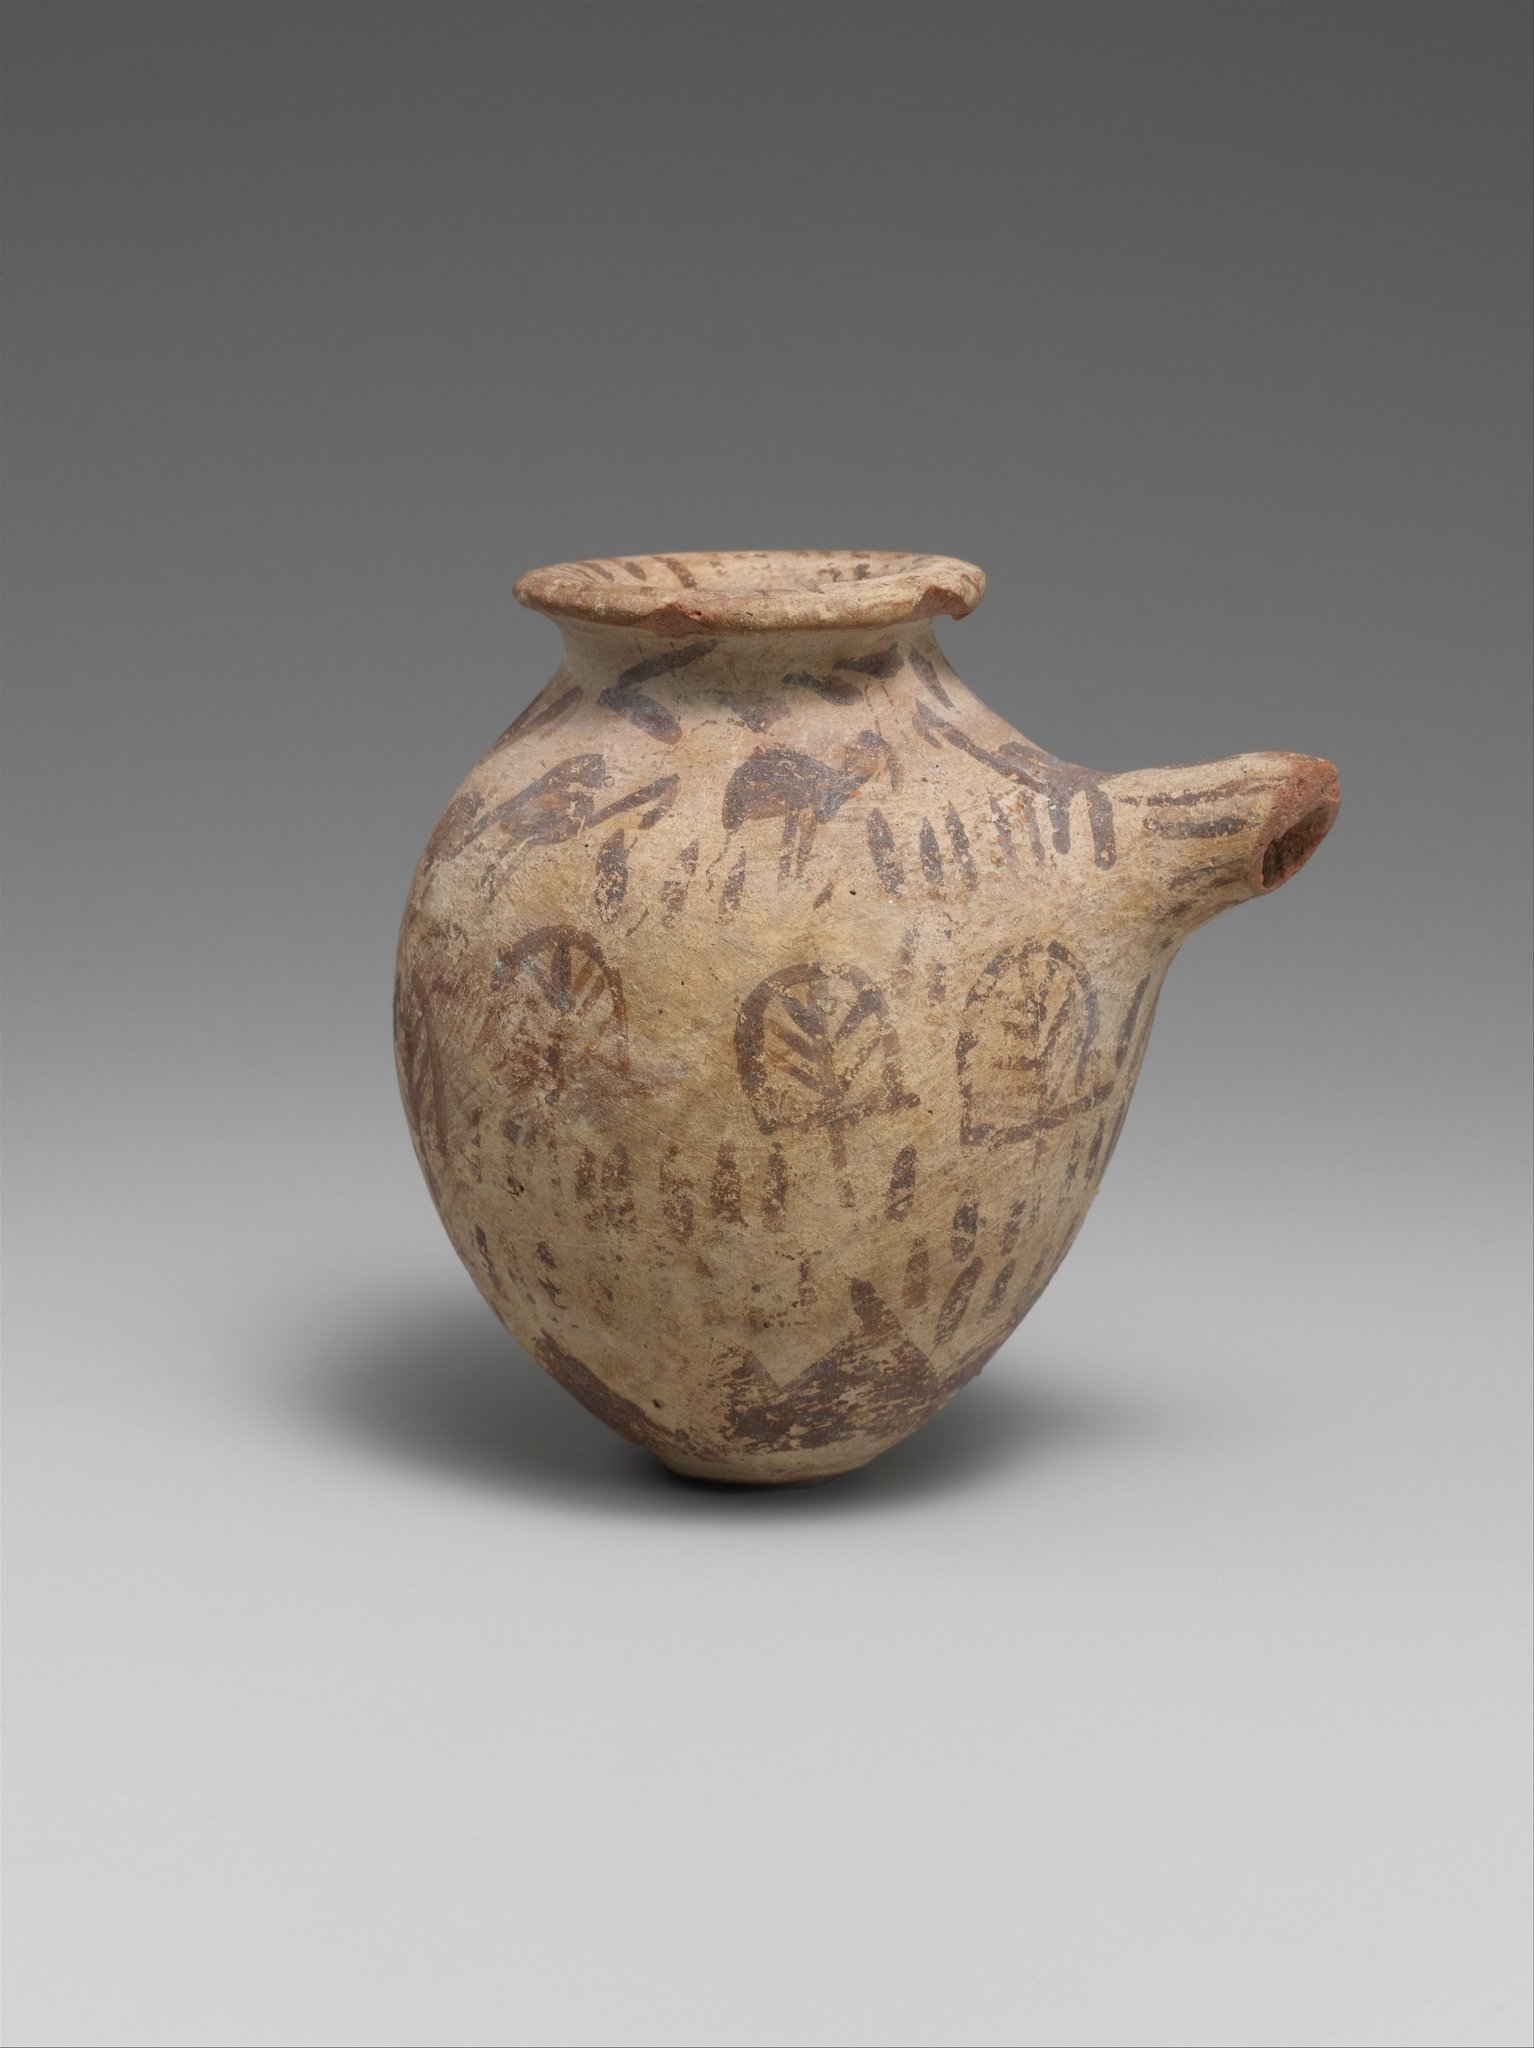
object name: vessel, decorated ware, spouted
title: Spouted vessel in decorated ware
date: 3500 BCE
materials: paint, pottery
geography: egypt